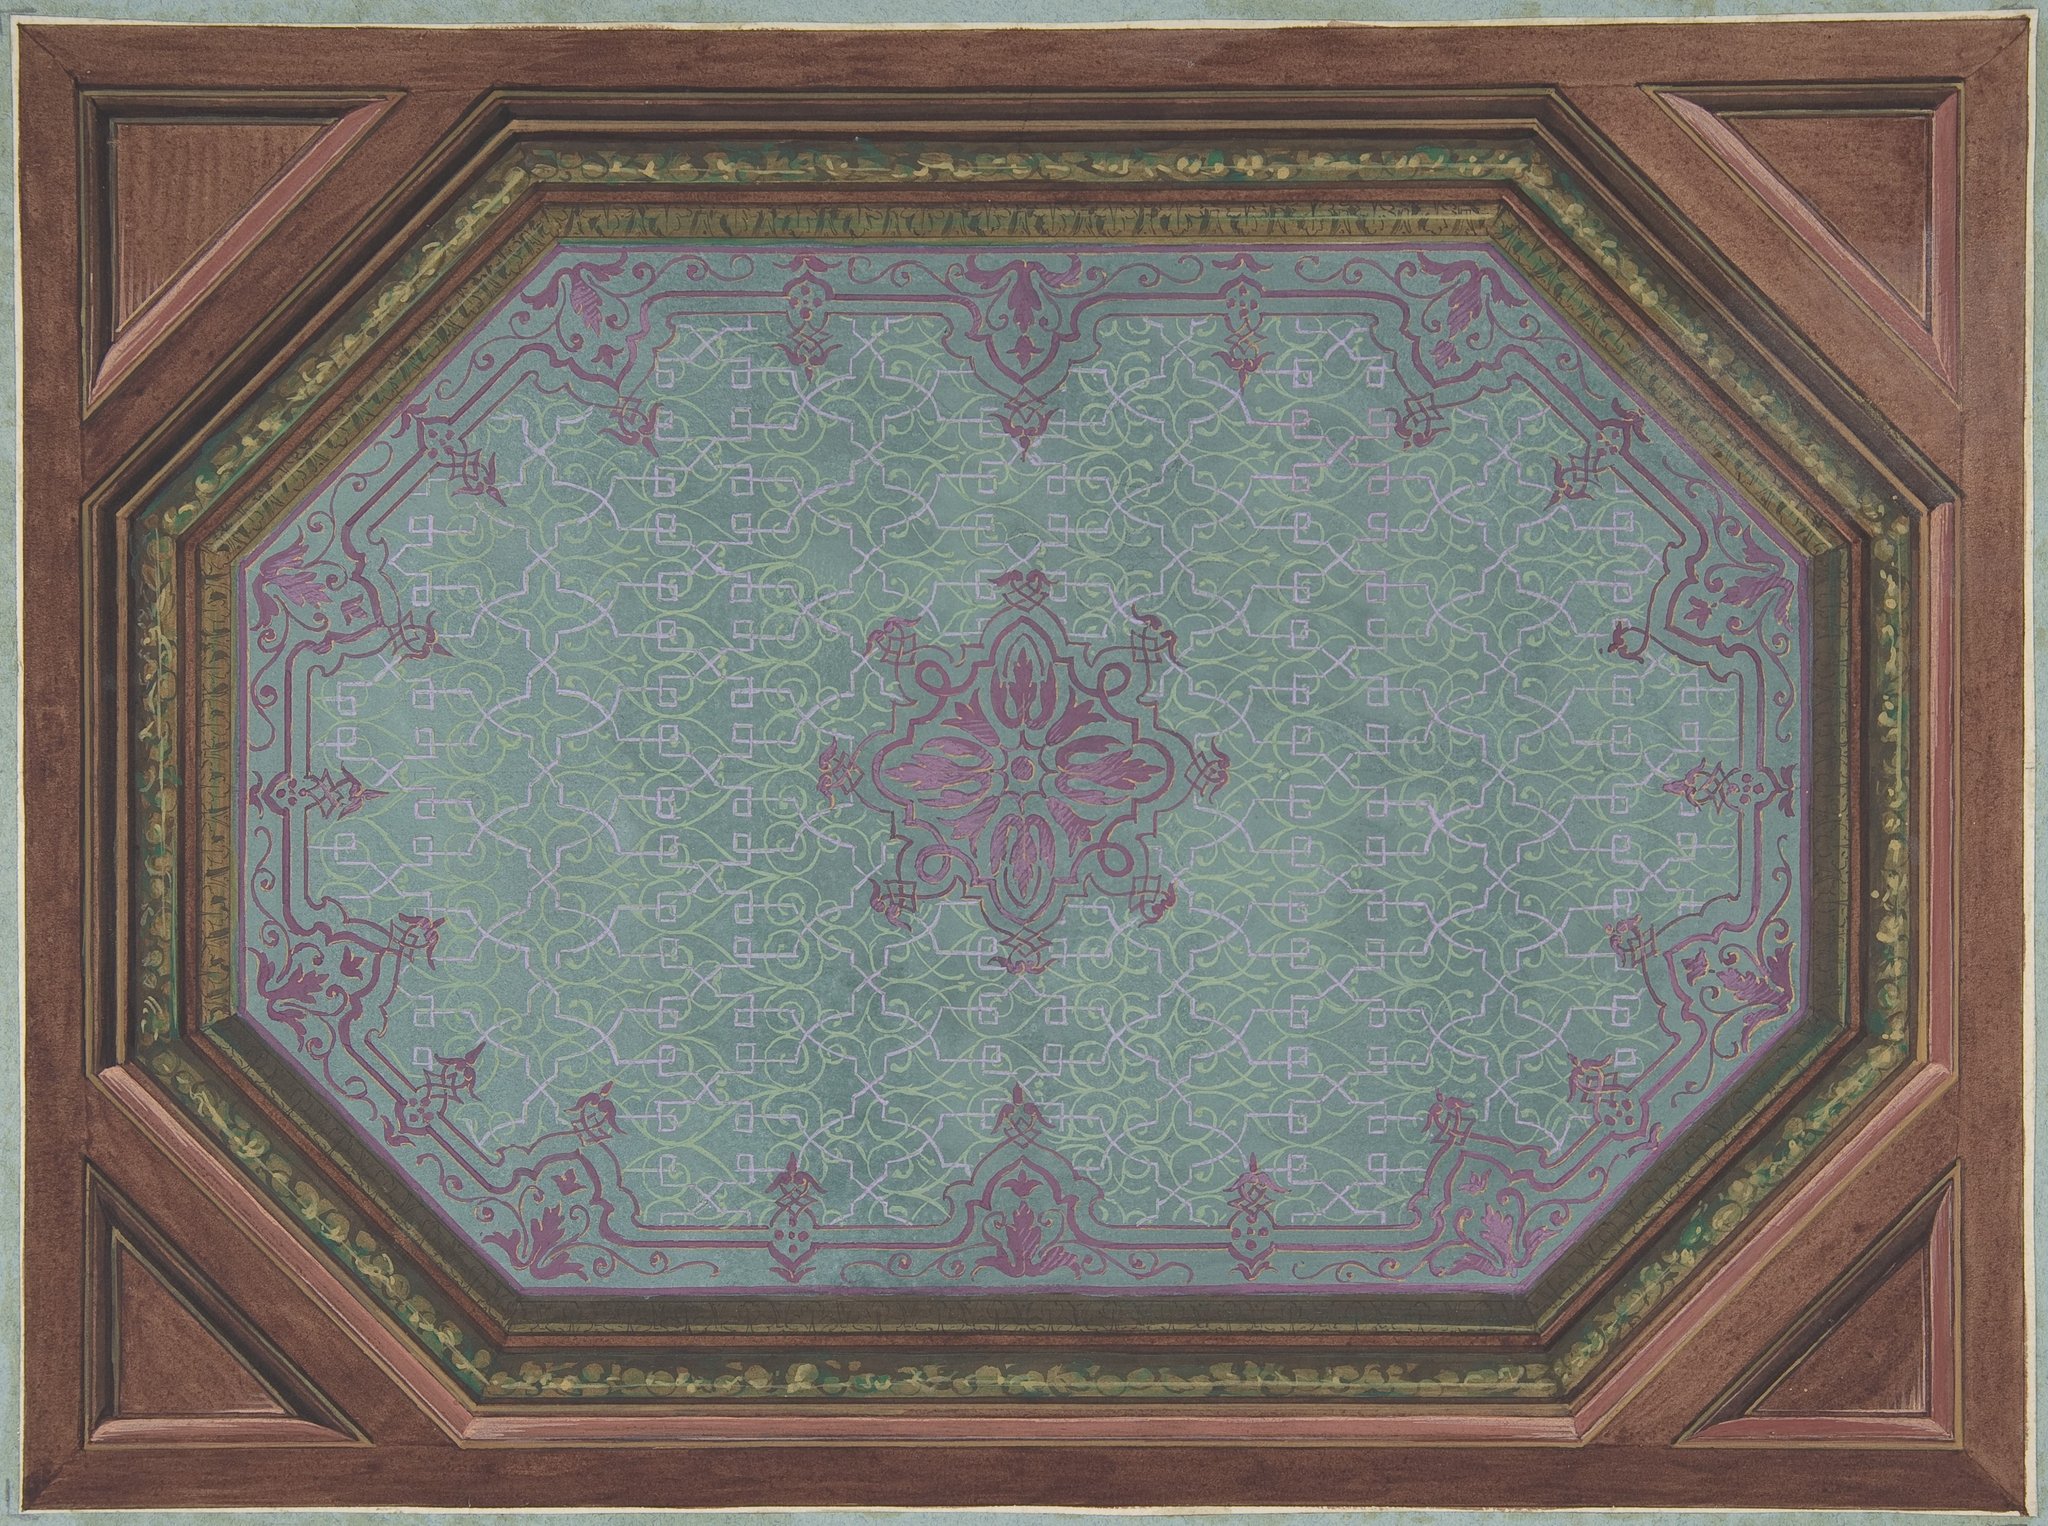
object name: drawing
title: Design for Ceiling, Hôtel Hope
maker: jules-edmond-charles lachaise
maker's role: artist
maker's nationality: french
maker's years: 1897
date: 1867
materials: gouache, ink, watercolor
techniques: pen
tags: ornament,ceilings